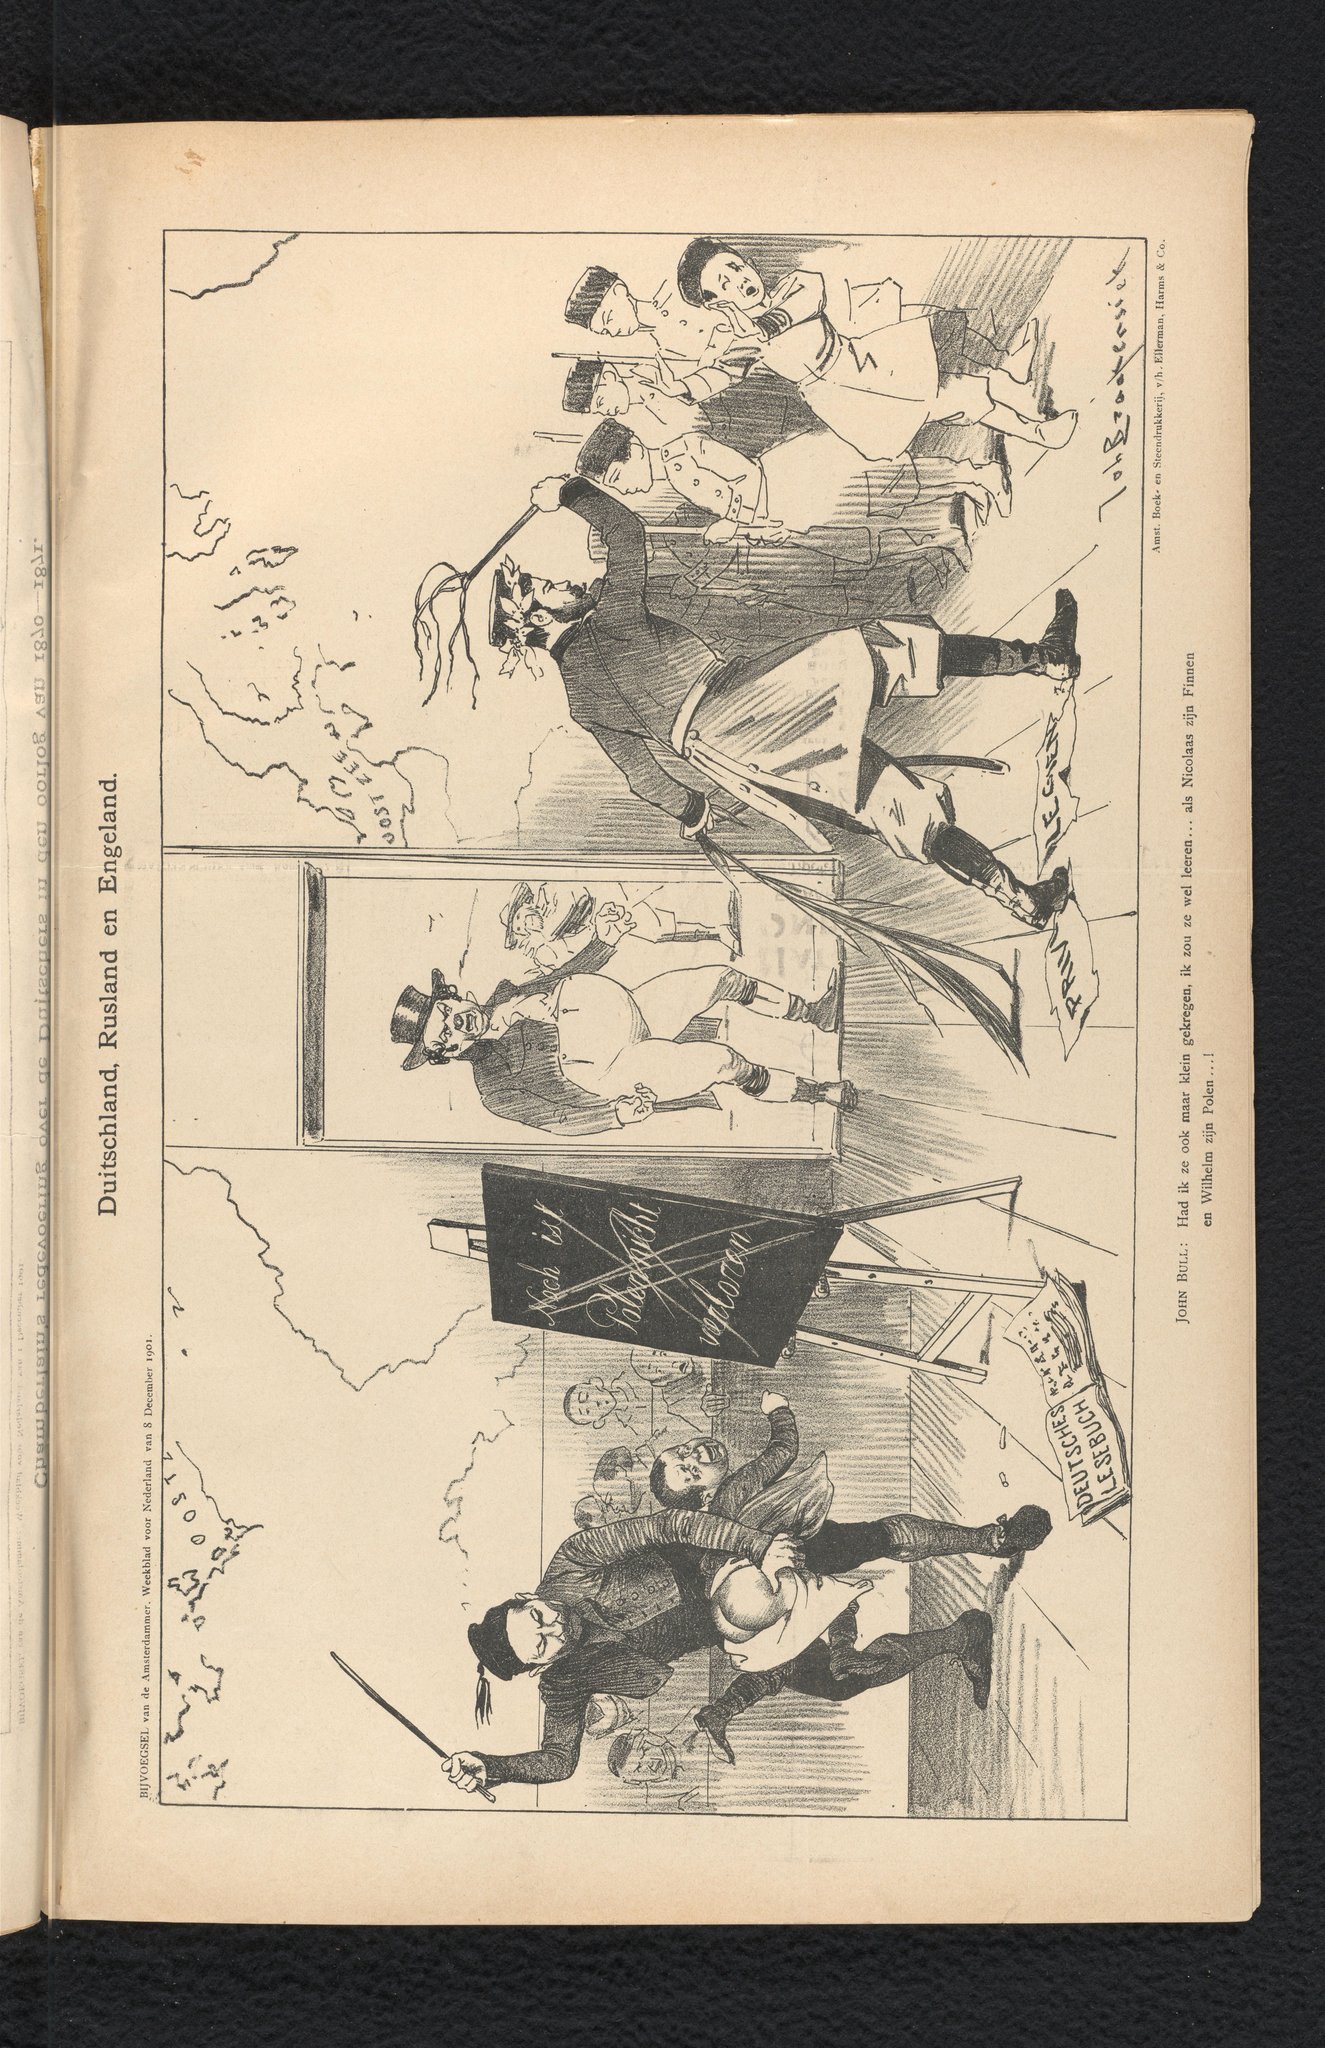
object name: cartoon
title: Duitschland, Rusland en Engeland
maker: johan braakensiek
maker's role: draughtsman, print maker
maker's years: 1858-1940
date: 1901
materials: paper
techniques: lithograph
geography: netherlands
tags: wilhelm ii (keizer van duitsland), personifications of countries, nations, states, districts, etc., corporal punishment at school: castigating, beating, etc., political caricatures and satires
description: In een klaslokaal worden door de meesters straf uitgedeeld aan ongehoorzame leerlingen, door Duitsland aan Polen en door Rusland aan Finland. John Bull (Engeland) heeft spijt dat hij de Zuid-Afrikaanse Boeren niet harder heeft aangepakt.